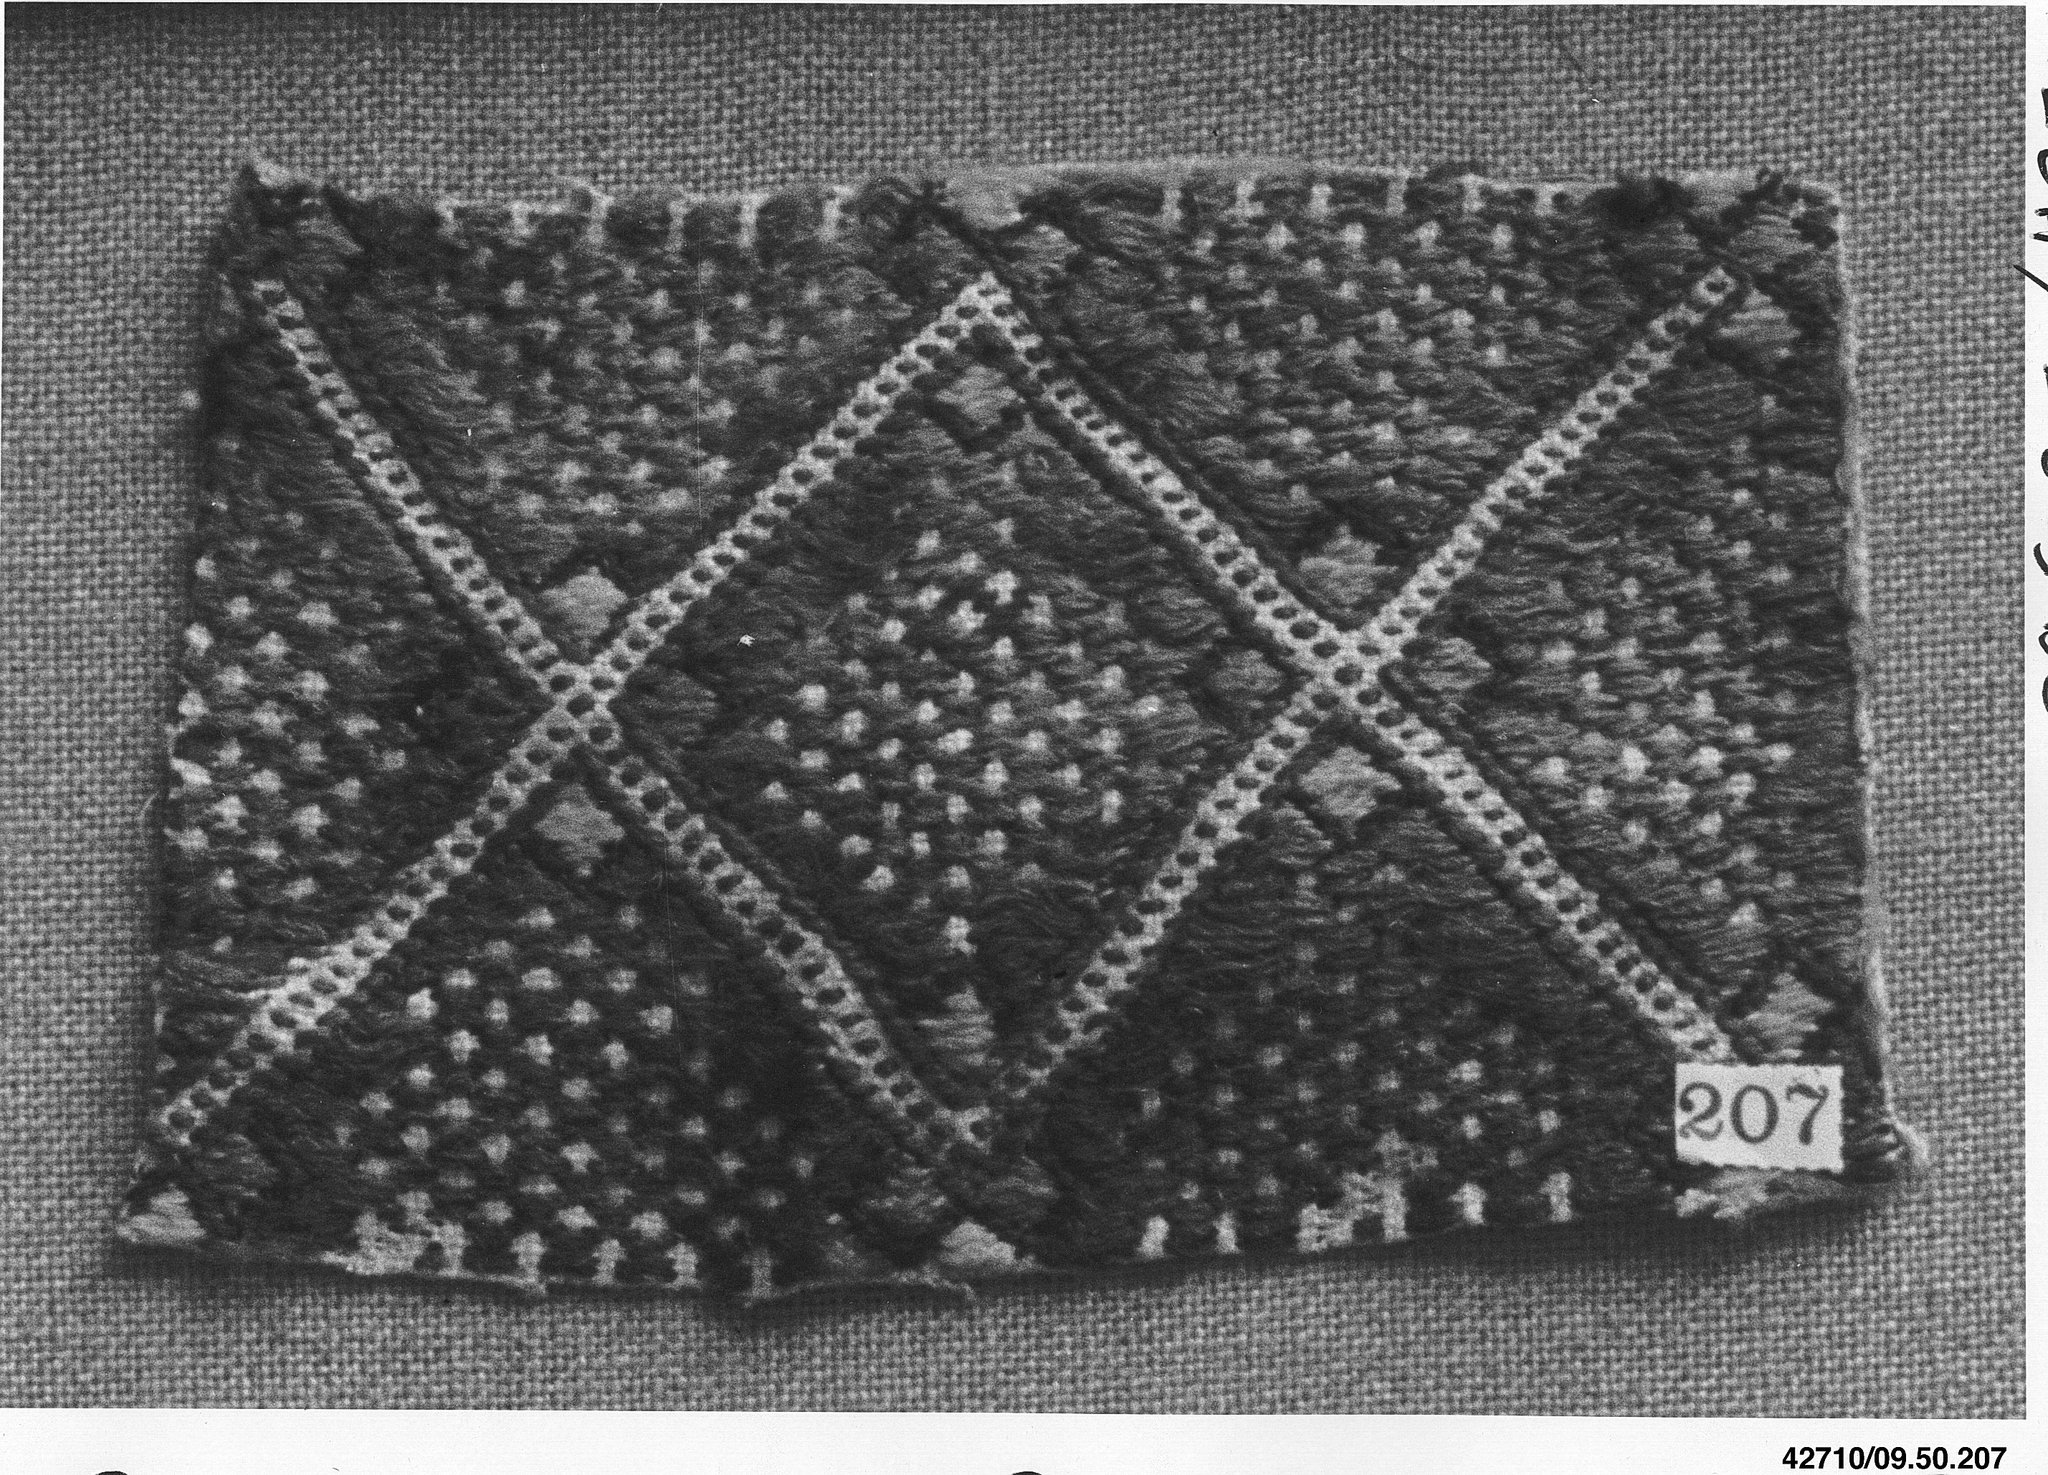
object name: costume fragment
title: Peasant costume fragment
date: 1701-1900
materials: canvas, wool